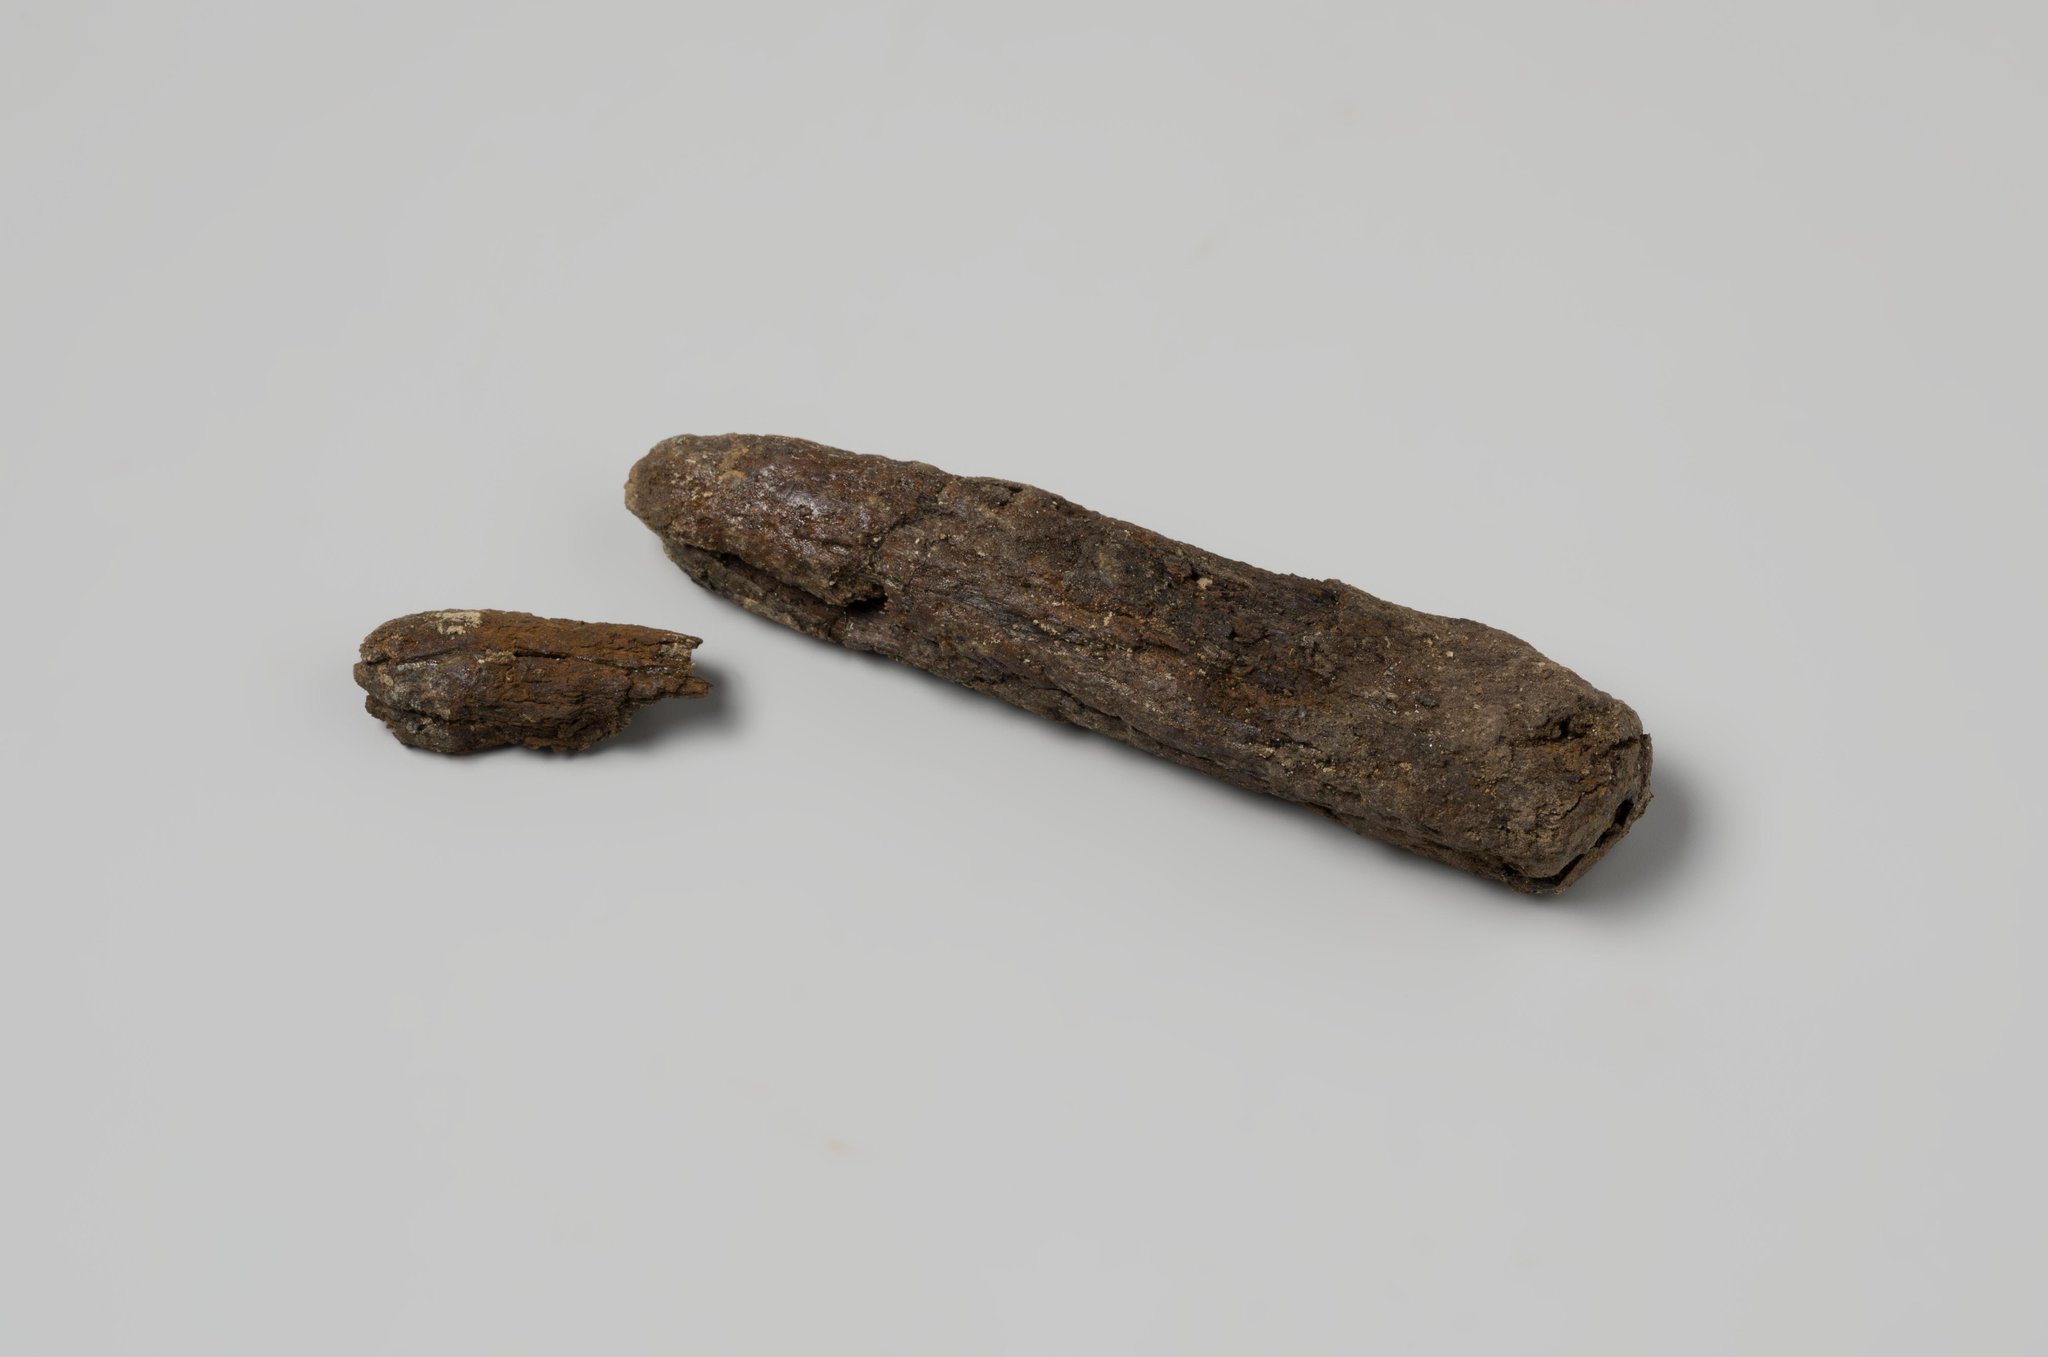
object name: knife handle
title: Messenheft uit het wrak van de Oost-Indiëvaarder Hollandia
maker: Anonymous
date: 1700-1743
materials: wood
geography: netherlands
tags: verenigde oostindische compagnie, hollandia (schip), annet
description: Knife, handle deformed: unclassifiable; fragm, probably cylindrical, tapering.